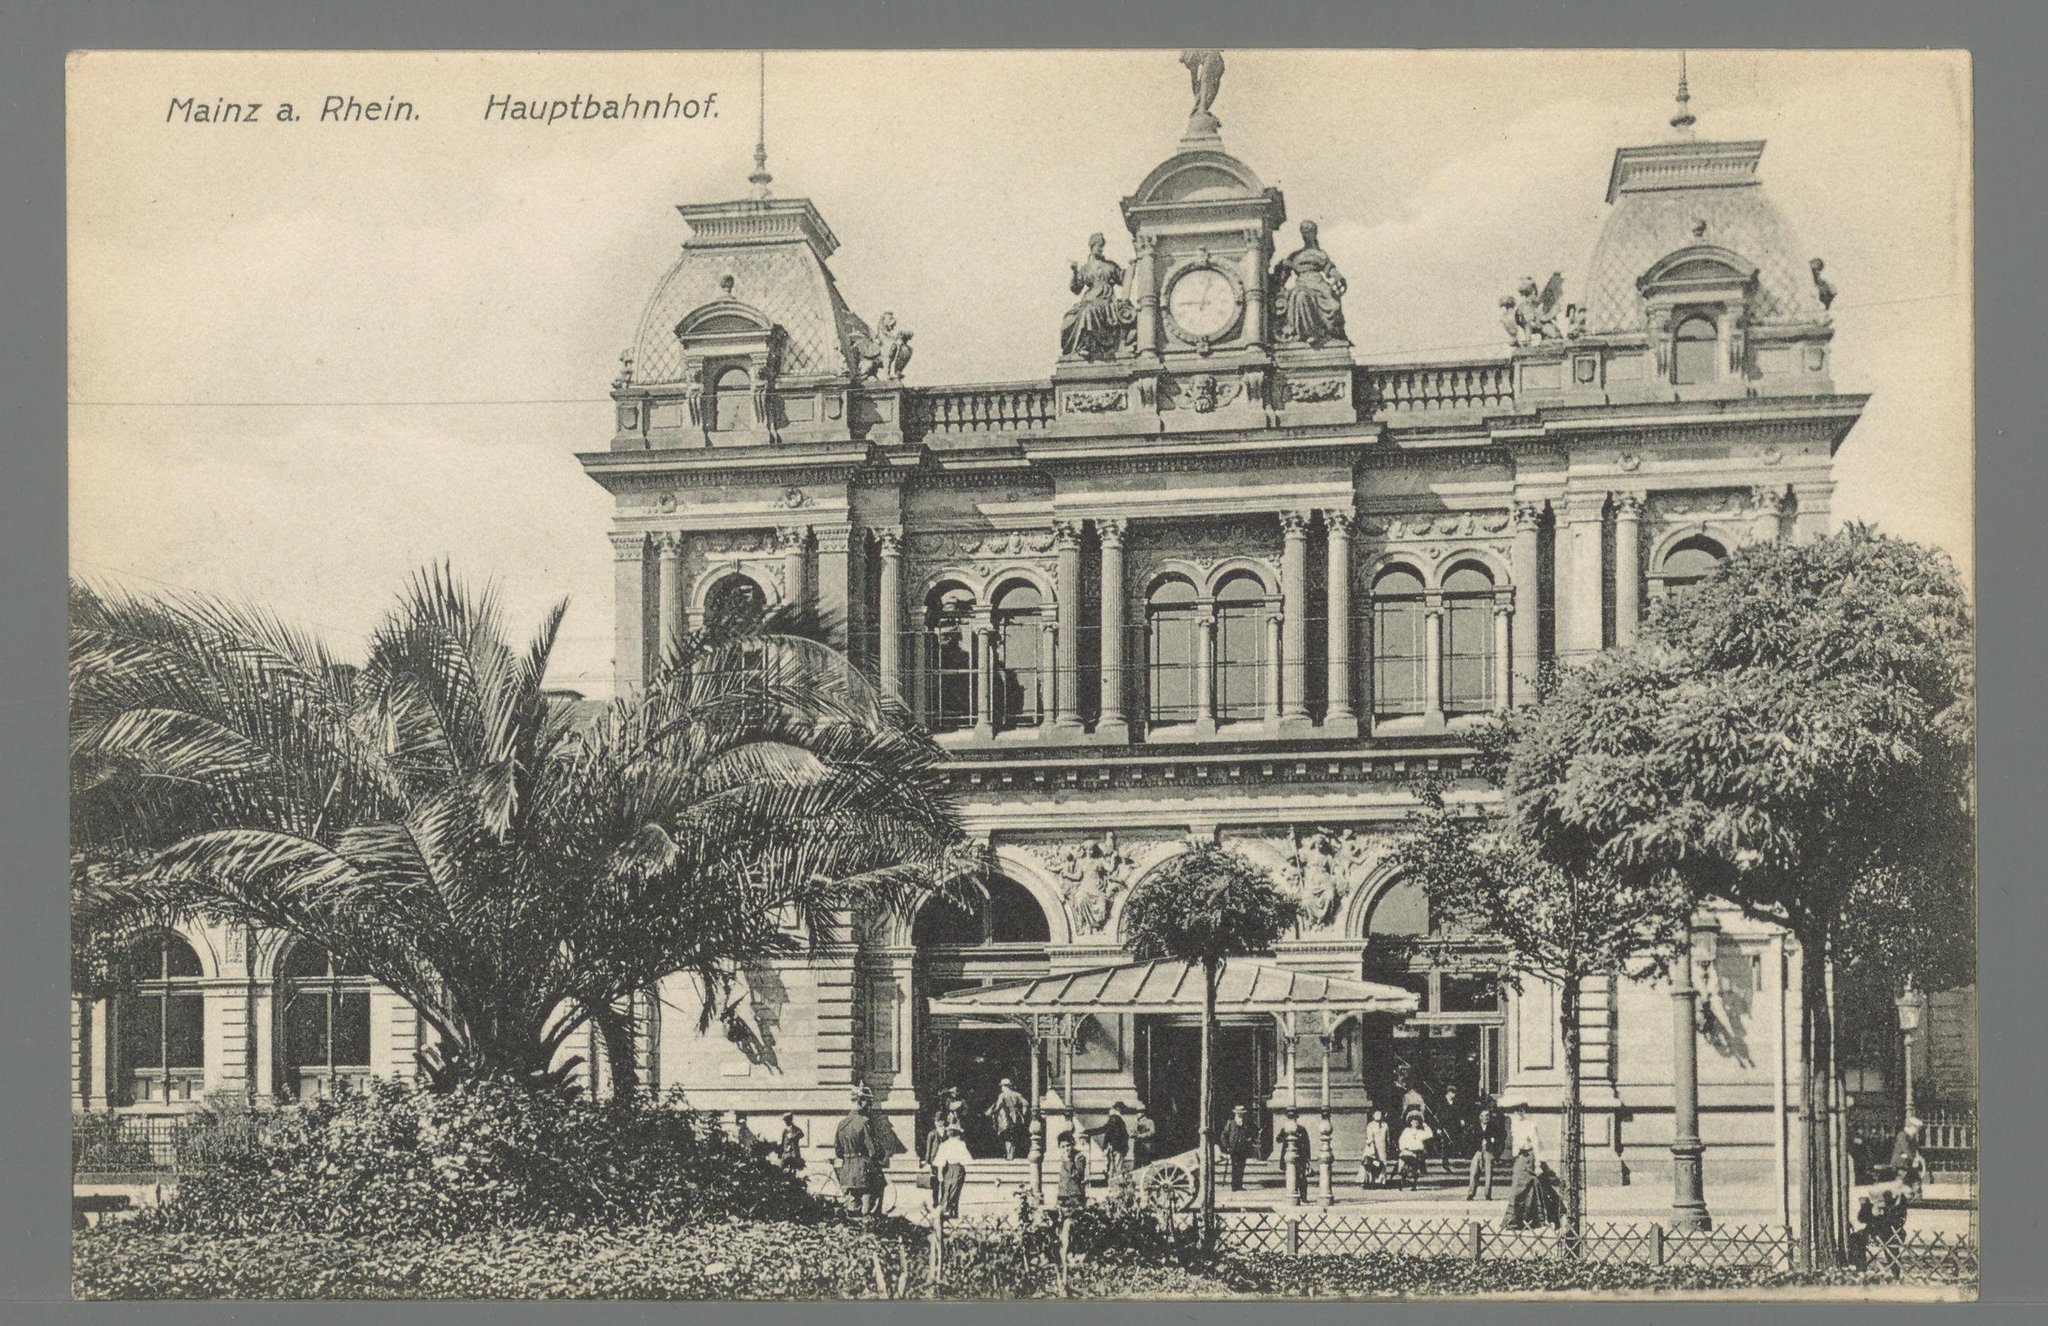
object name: photomechanical print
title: Mainz a. Rhein. Hauptbahnhof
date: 1905-1908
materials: cardboard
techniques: photograph, writing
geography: darmstadt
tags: station; shelter (railway, tramway)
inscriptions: inscription: ‘K.W.M.’